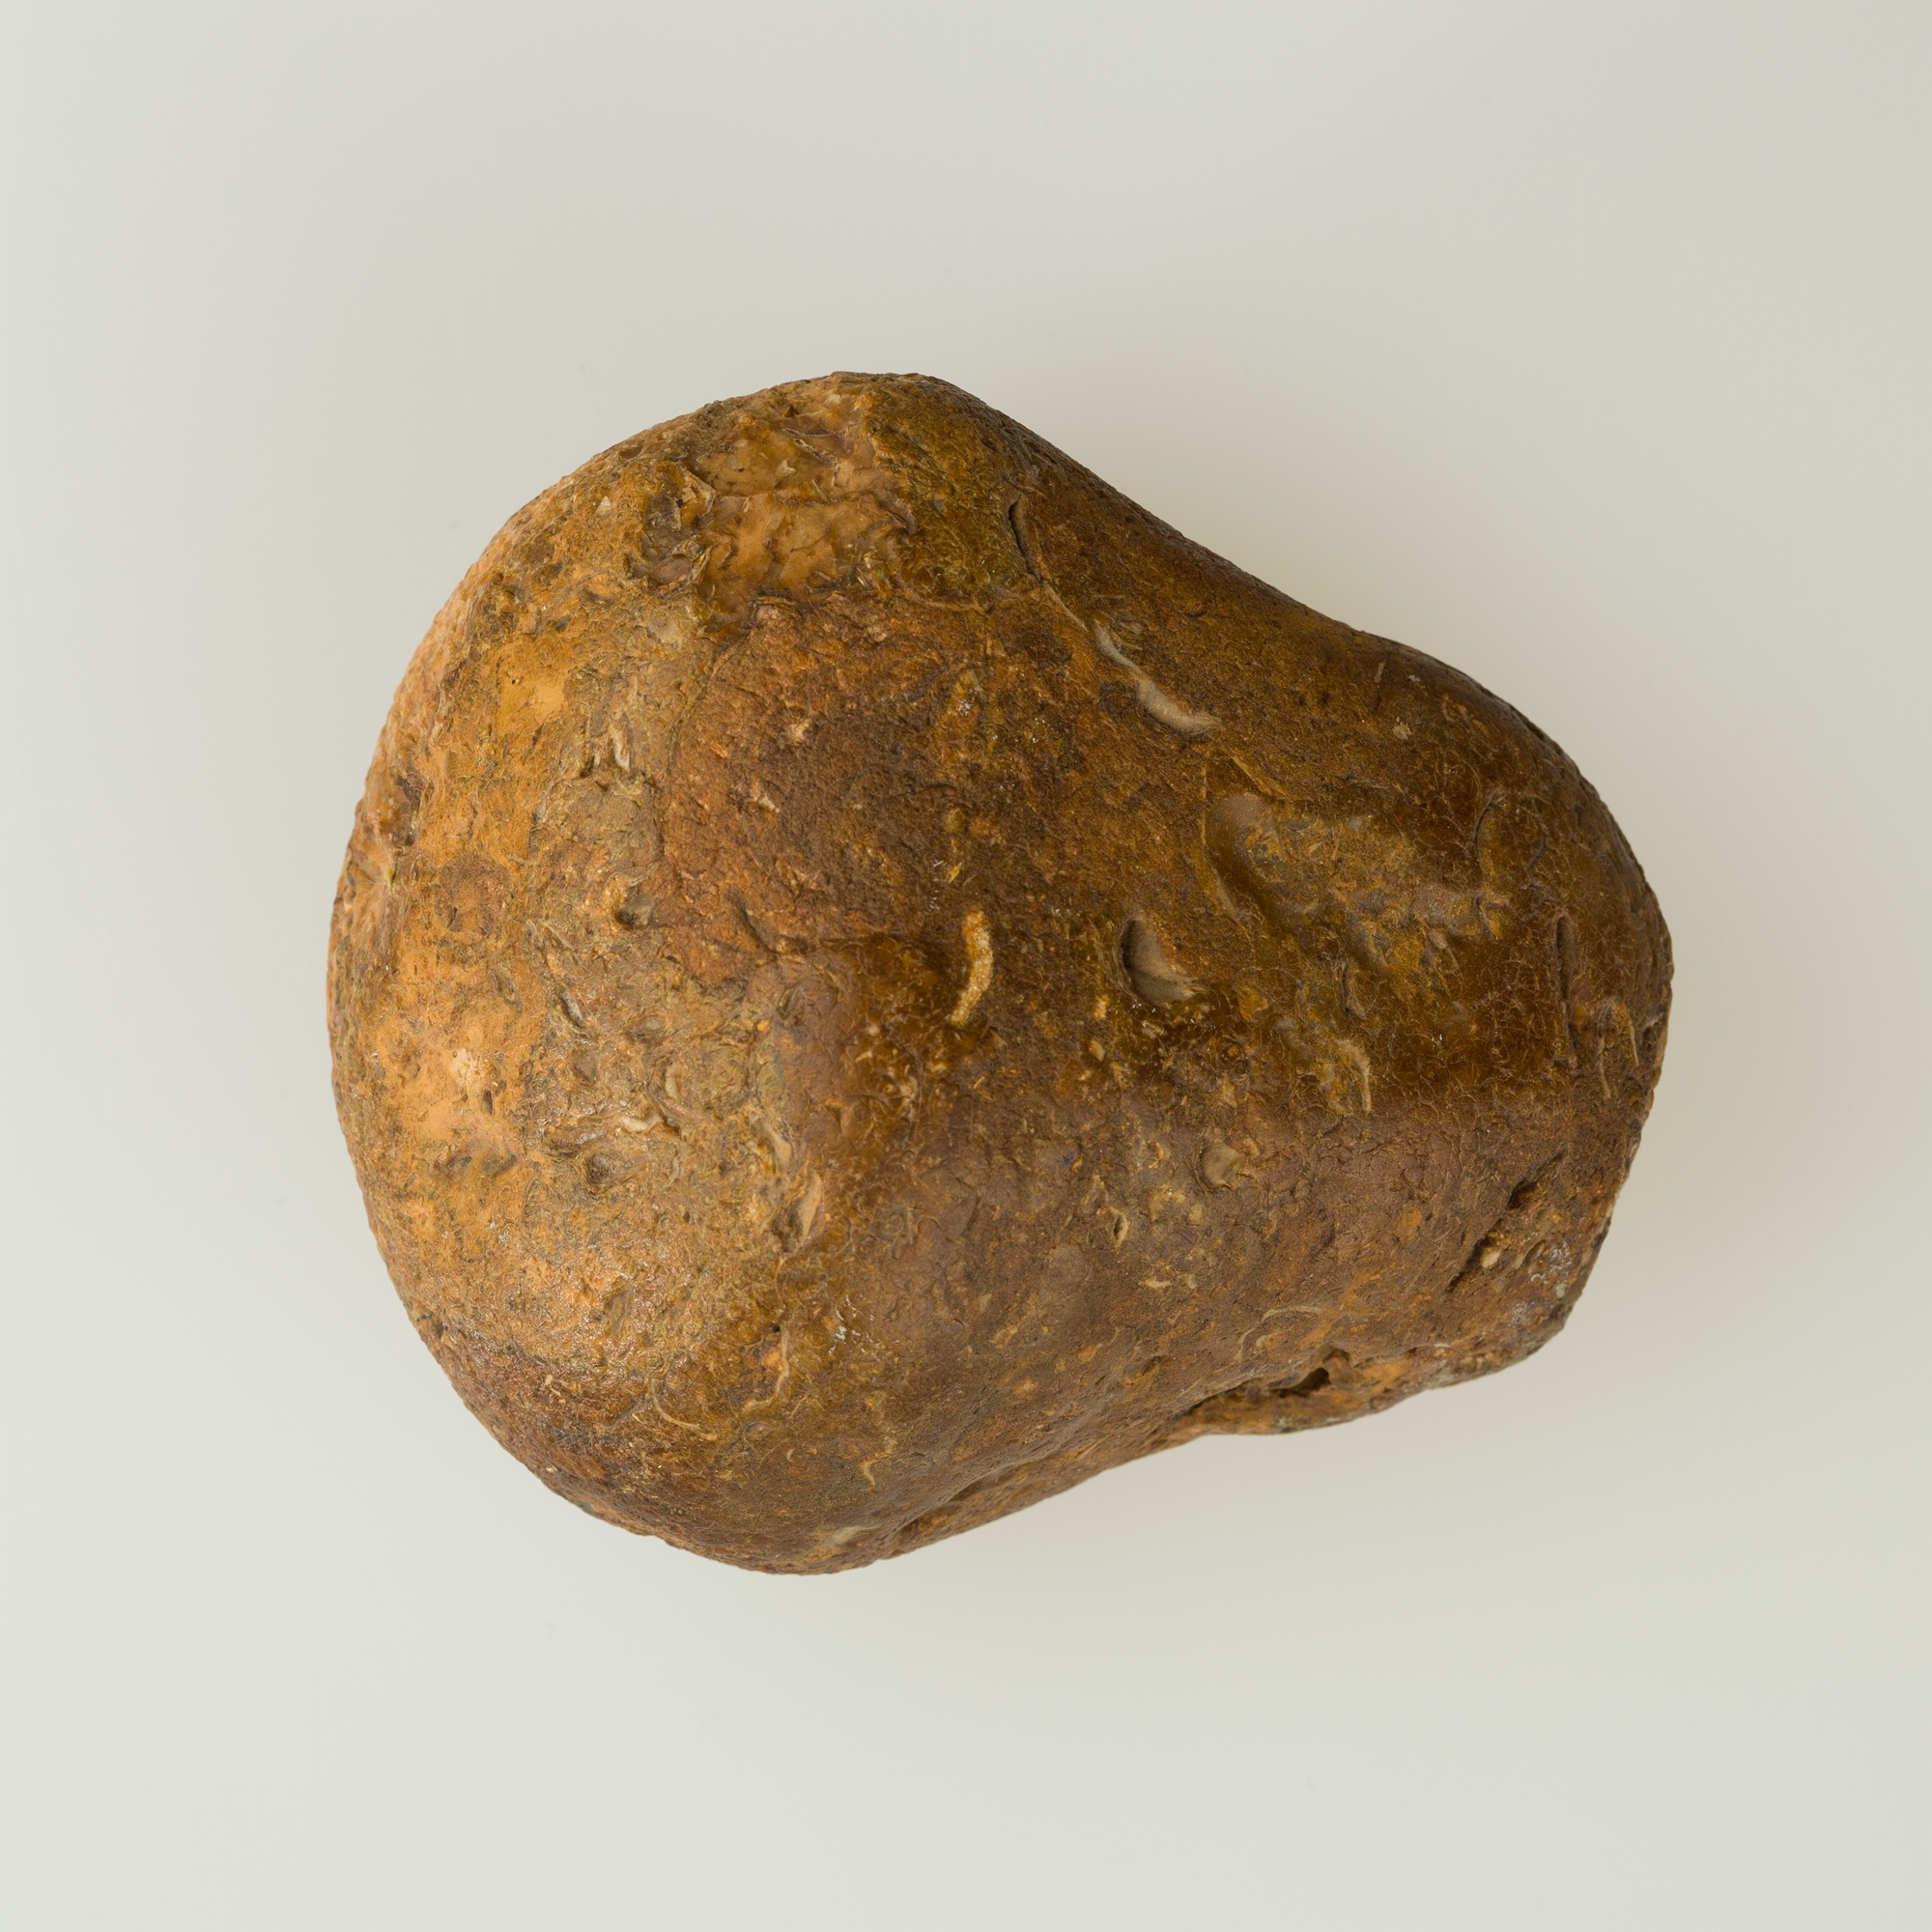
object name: pestle, pounder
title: Pounder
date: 4500-4000 BCE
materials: quartz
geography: egypt